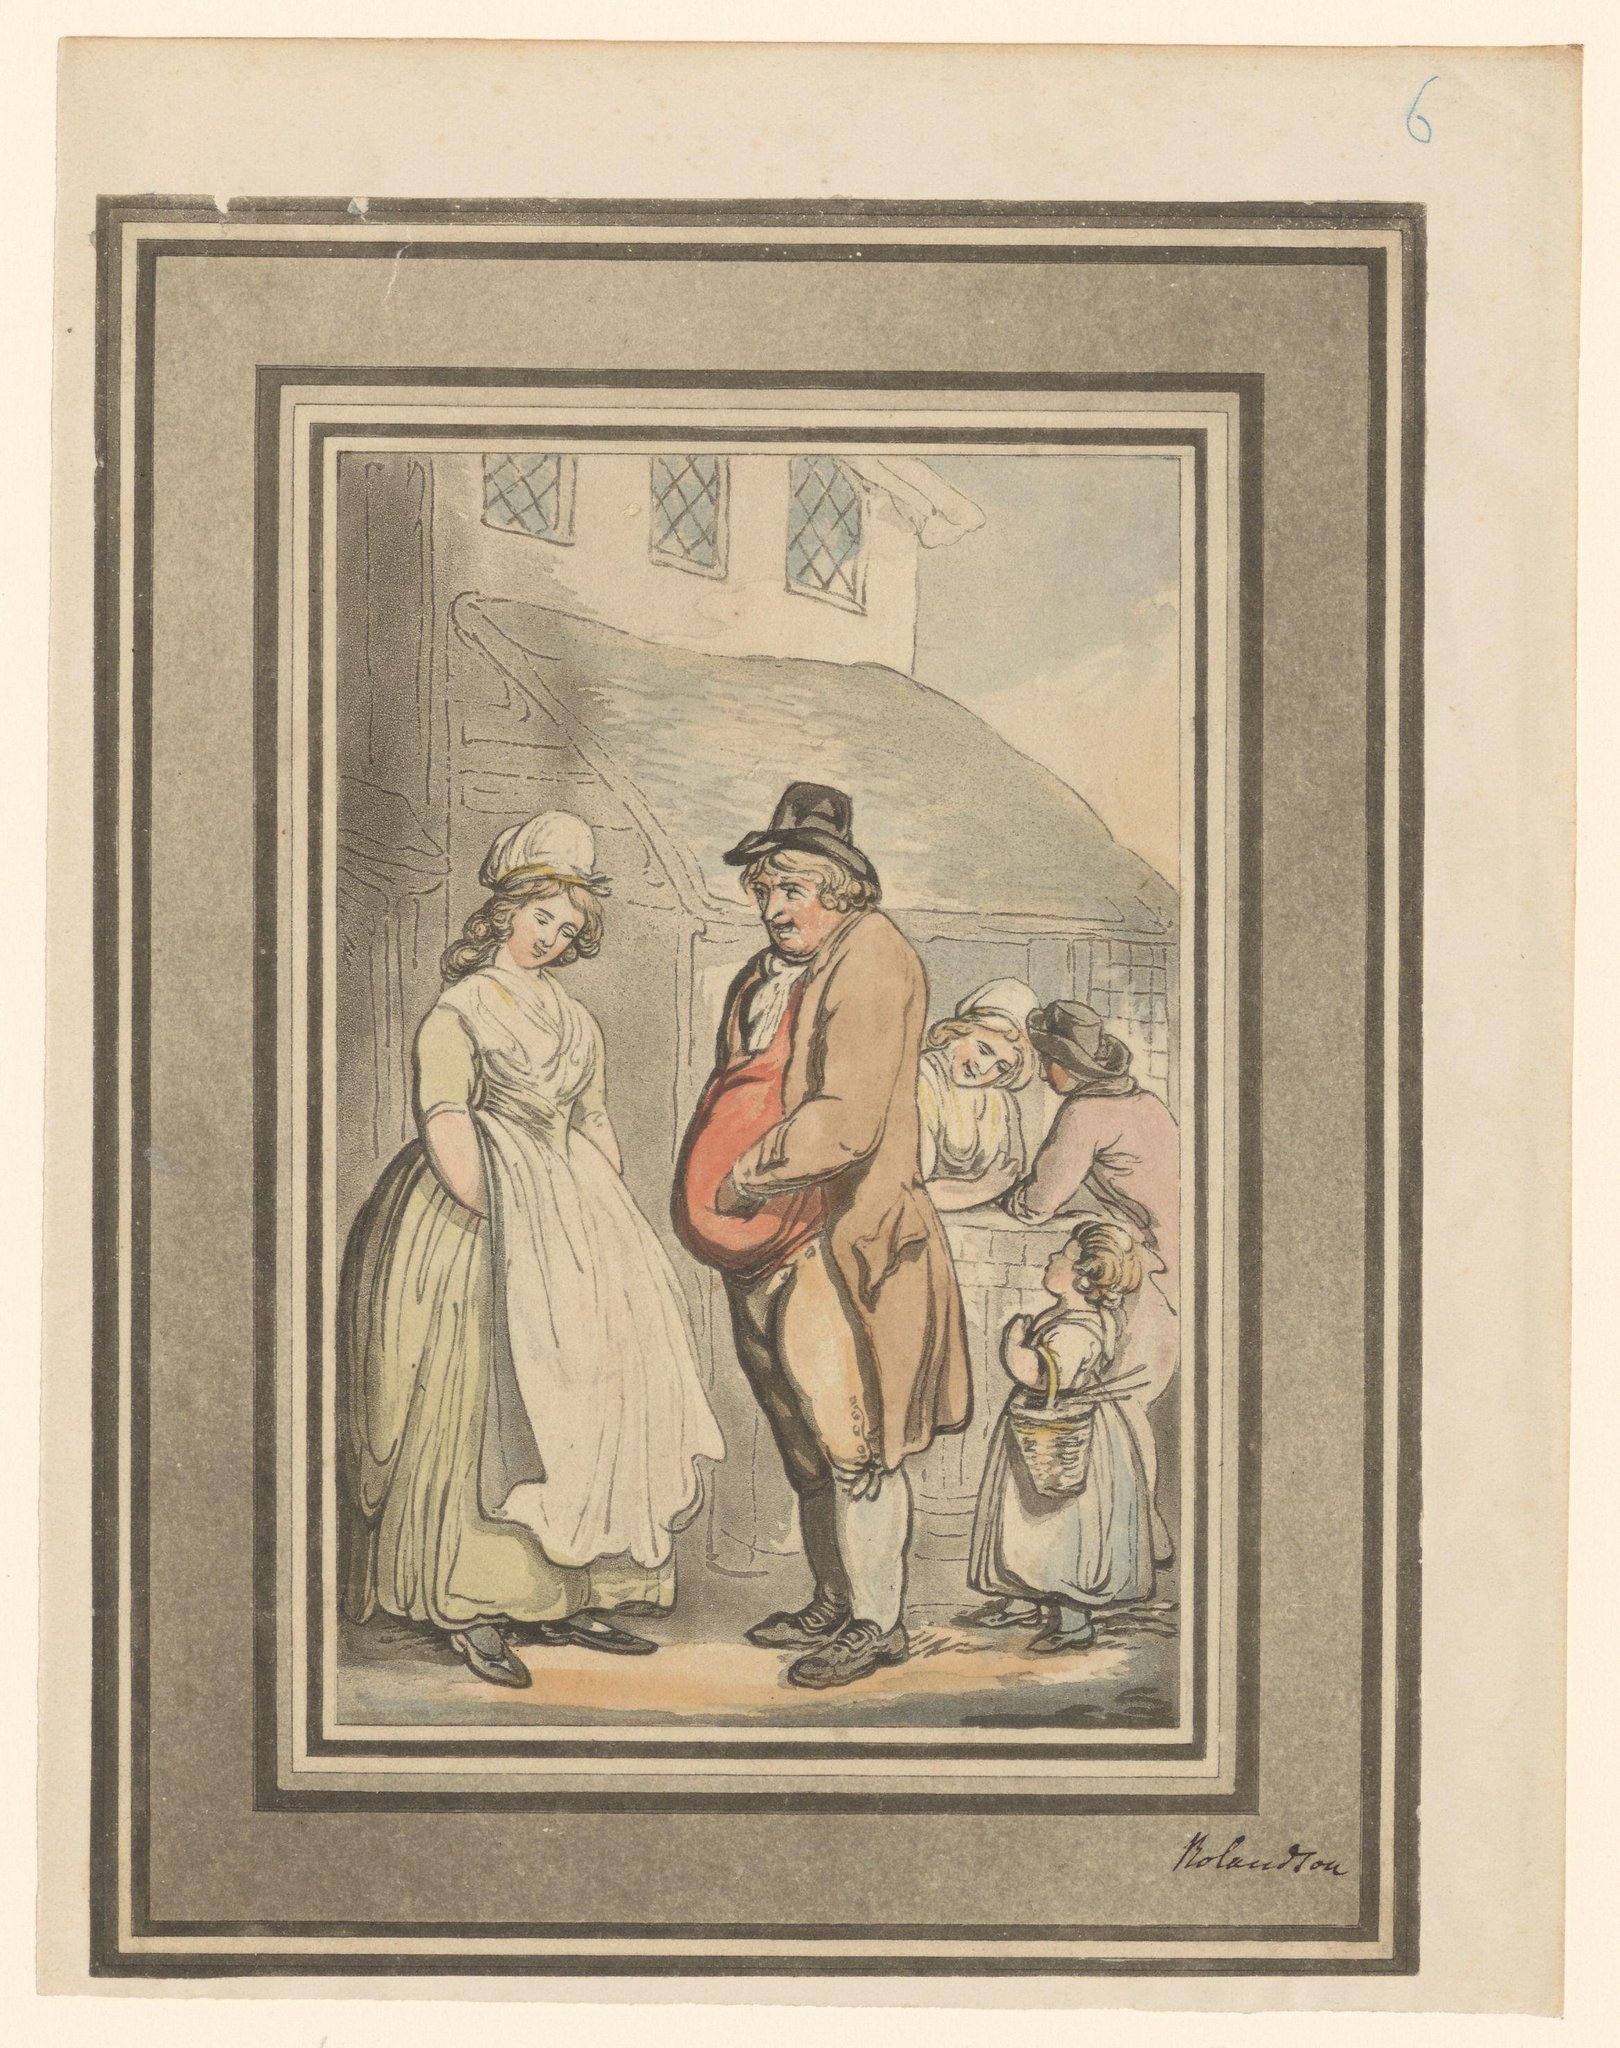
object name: print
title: Man en vrouw in een dorp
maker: thomas rowlandson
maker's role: draughtsman, print maker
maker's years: 1756-1827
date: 1766-1827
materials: paper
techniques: aquatint, etching, hand coloring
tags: lovers; courting, flirting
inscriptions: collector's mark: Lugt 2228